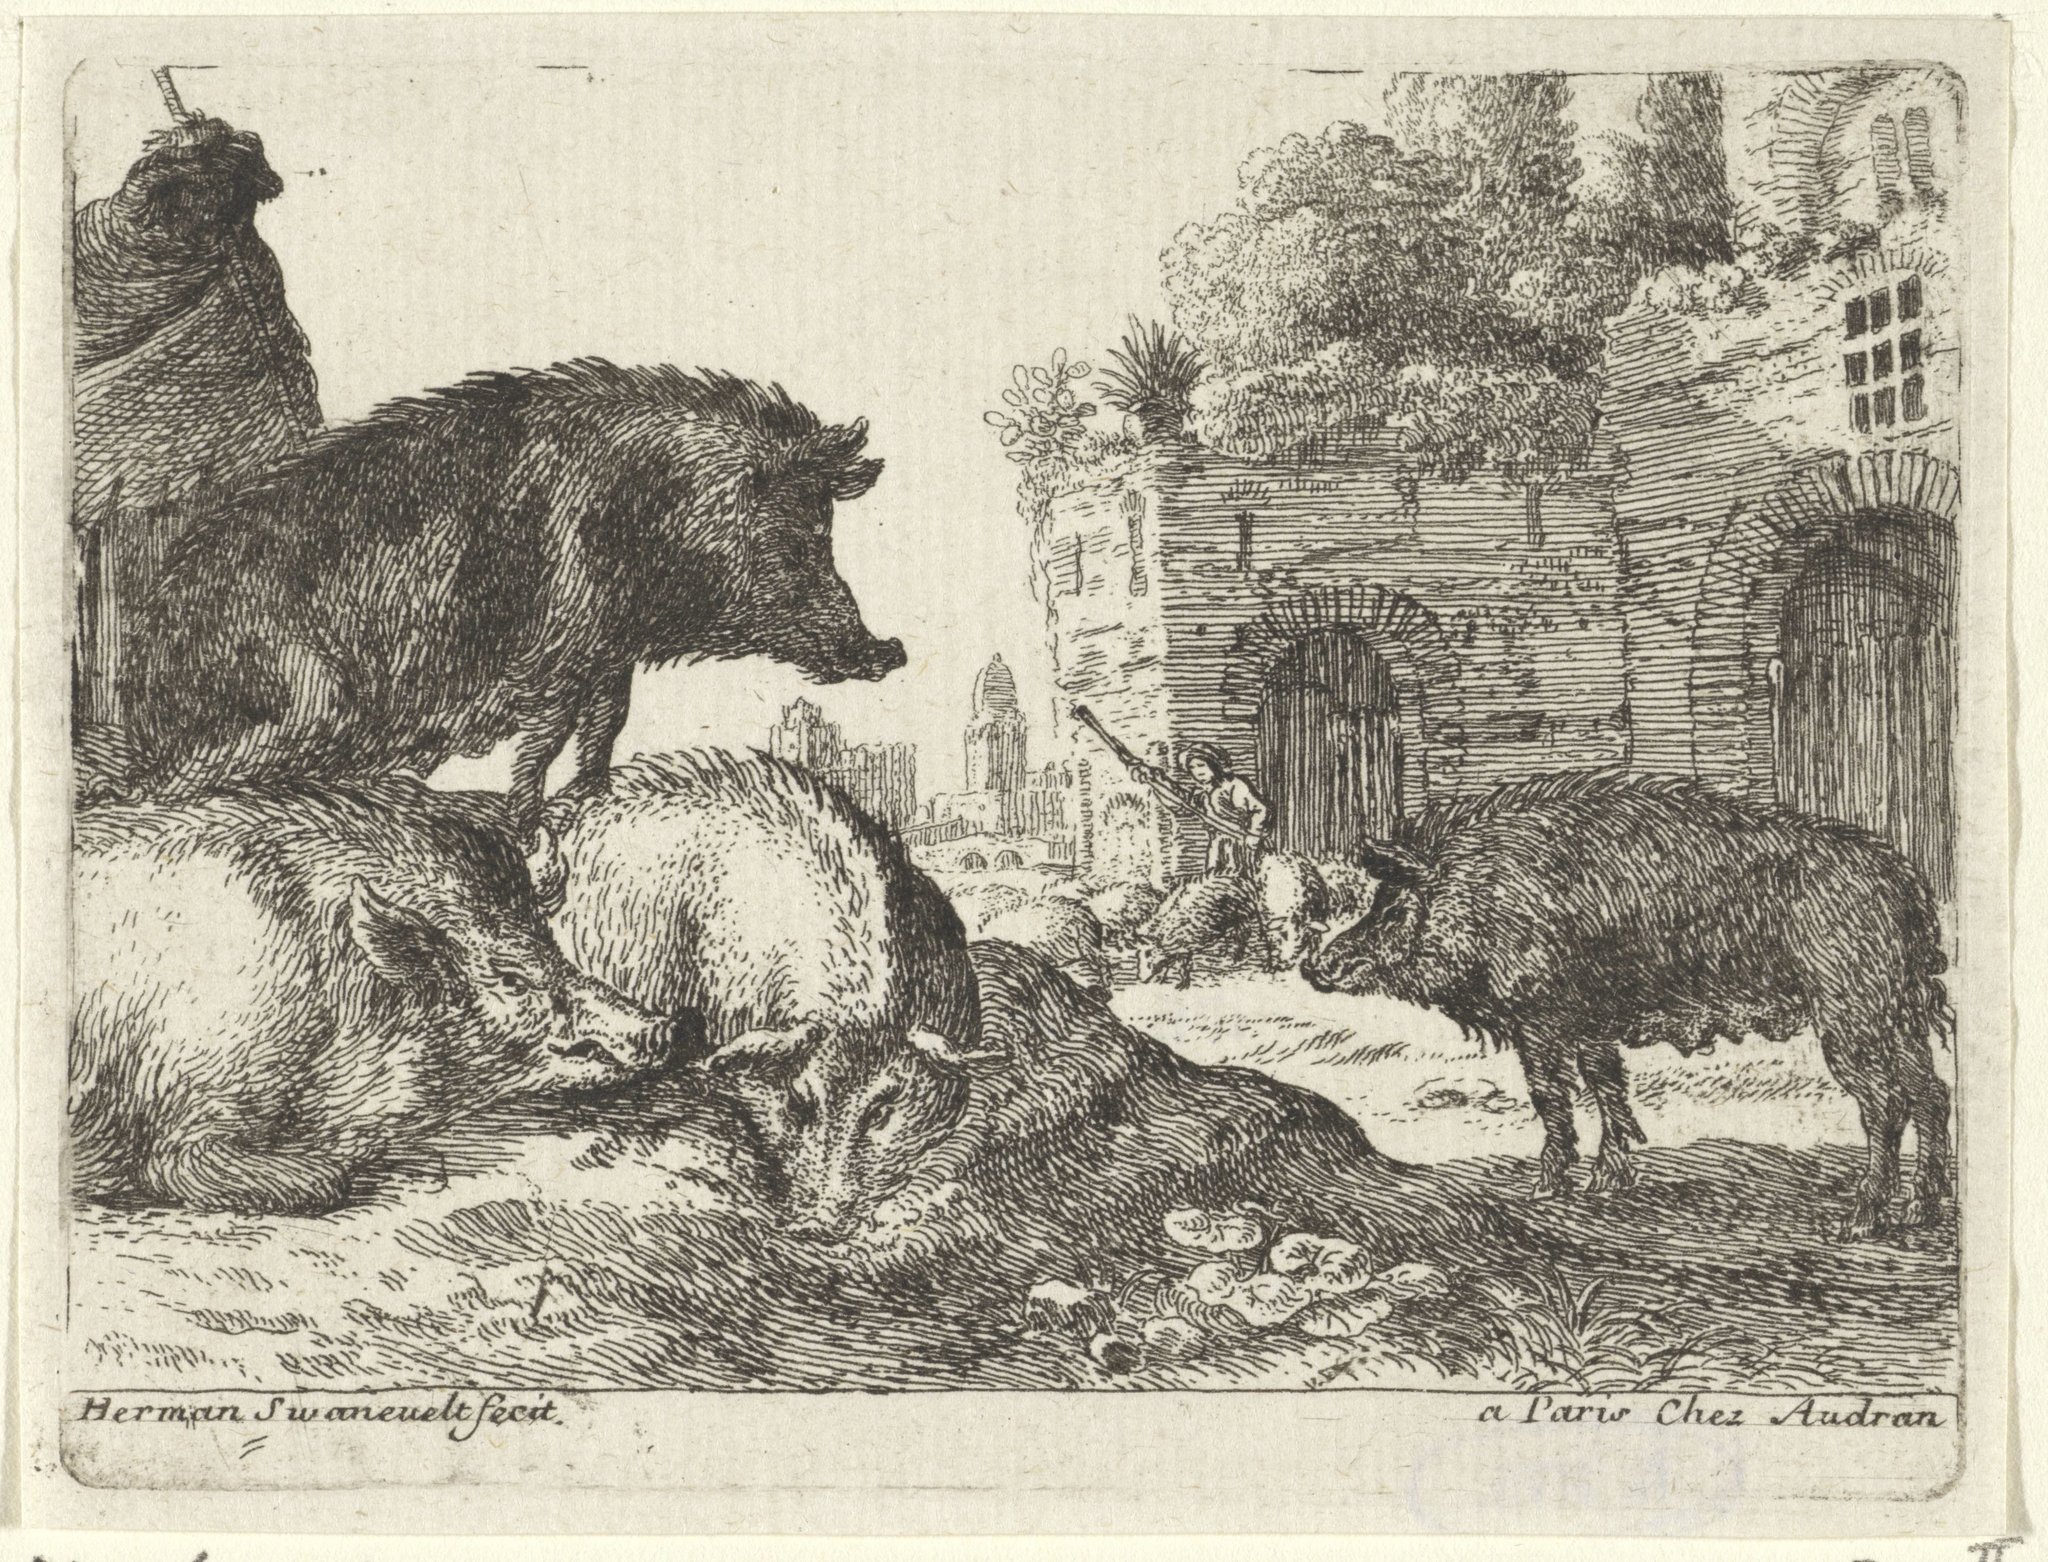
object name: print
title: Landschappen met dieren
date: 1643-1655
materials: paper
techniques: etching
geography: paris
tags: pig, landscapes, herding, herdsman, herdswoman, shepherd, shepherdess, cowherd, etc., rural housing, e.g. country-house, villa, cottage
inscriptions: collector's mark: Lugt 2228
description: Een herder staat bij vier varkens, terwijl op de achtergrond een andere herder met enkele varkens voor een gebouw staat.